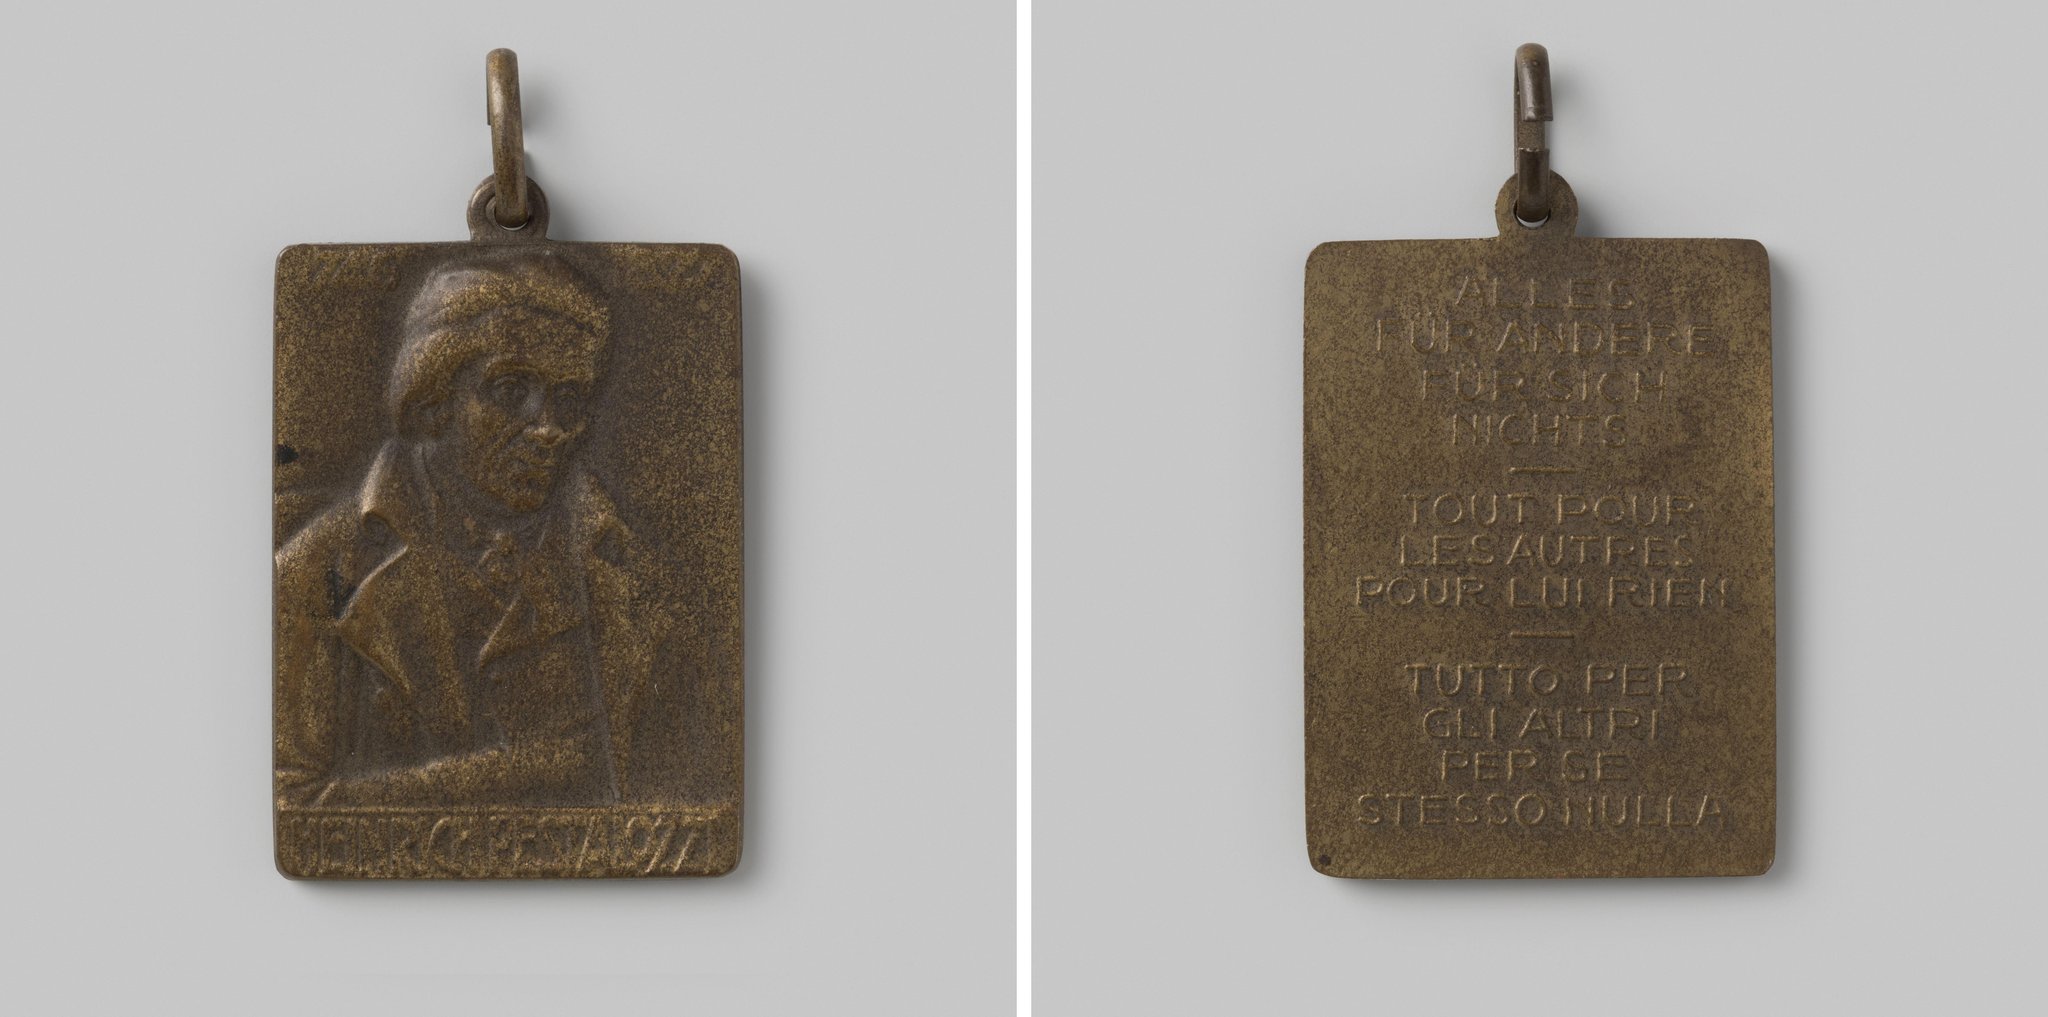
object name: history medal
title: Heinrich Pestalozzi 1746-1827 (1927)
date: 1927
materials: brass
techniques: pressing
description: Rechthoekige messing plaquette met oog en draagring, op de voorzijde Pestalozzi ten halven lijve, bovenaan twee jaartallen, onderaan een band met tekst, op de keerzijde elf regels tekst.